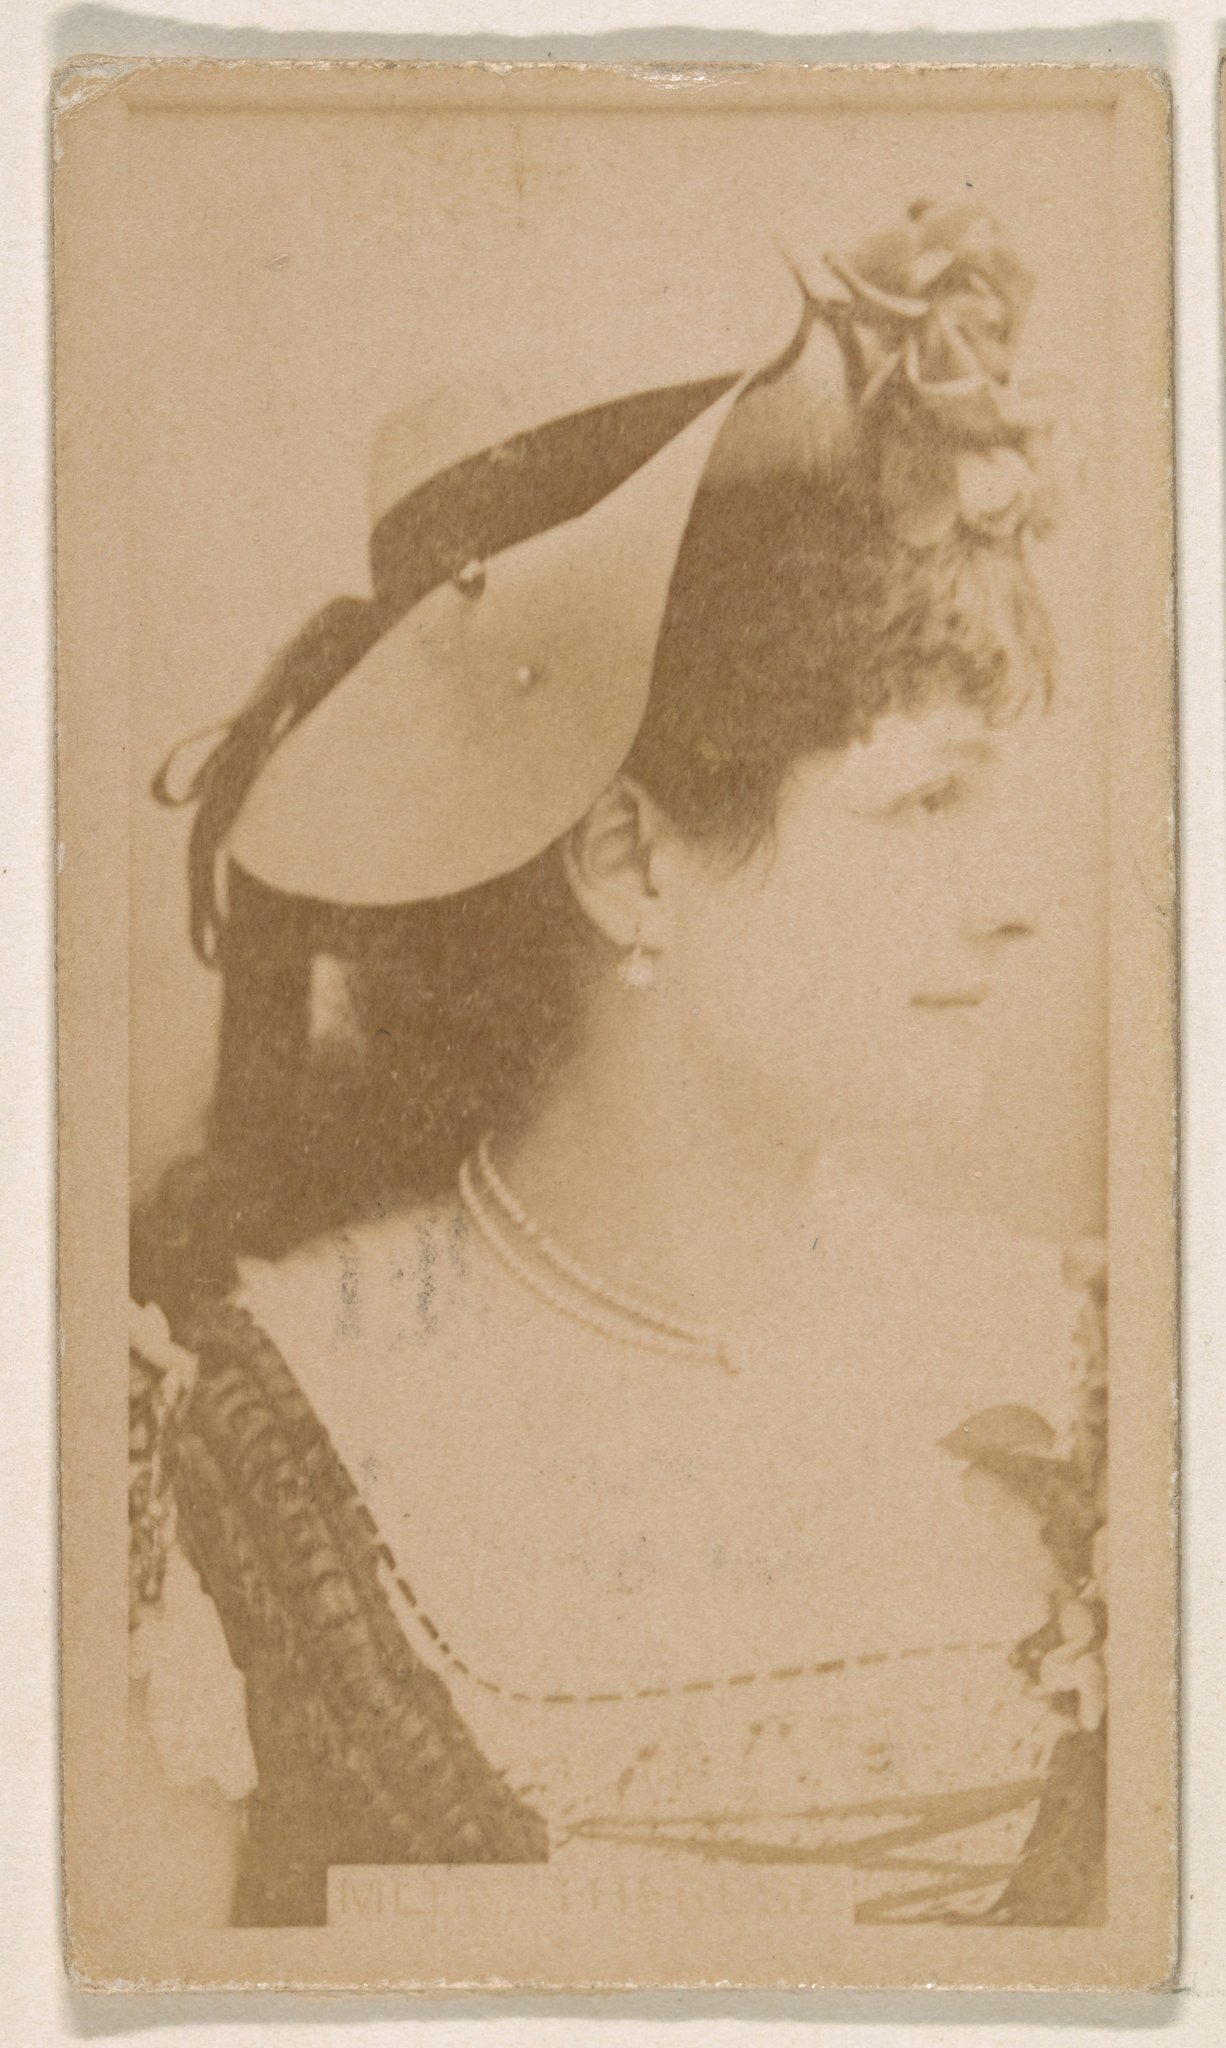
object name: photograph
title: Actress in profile wearing hat with blossoms, from the Actresses series (N245) issued by Kinney Brothers to promote Sweet Caporal Cigarettes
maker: kinney brothers tobacco company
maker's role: publisher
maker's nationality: american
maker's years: 1869-2011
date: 1890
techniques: albumen silver print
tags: women,actresses